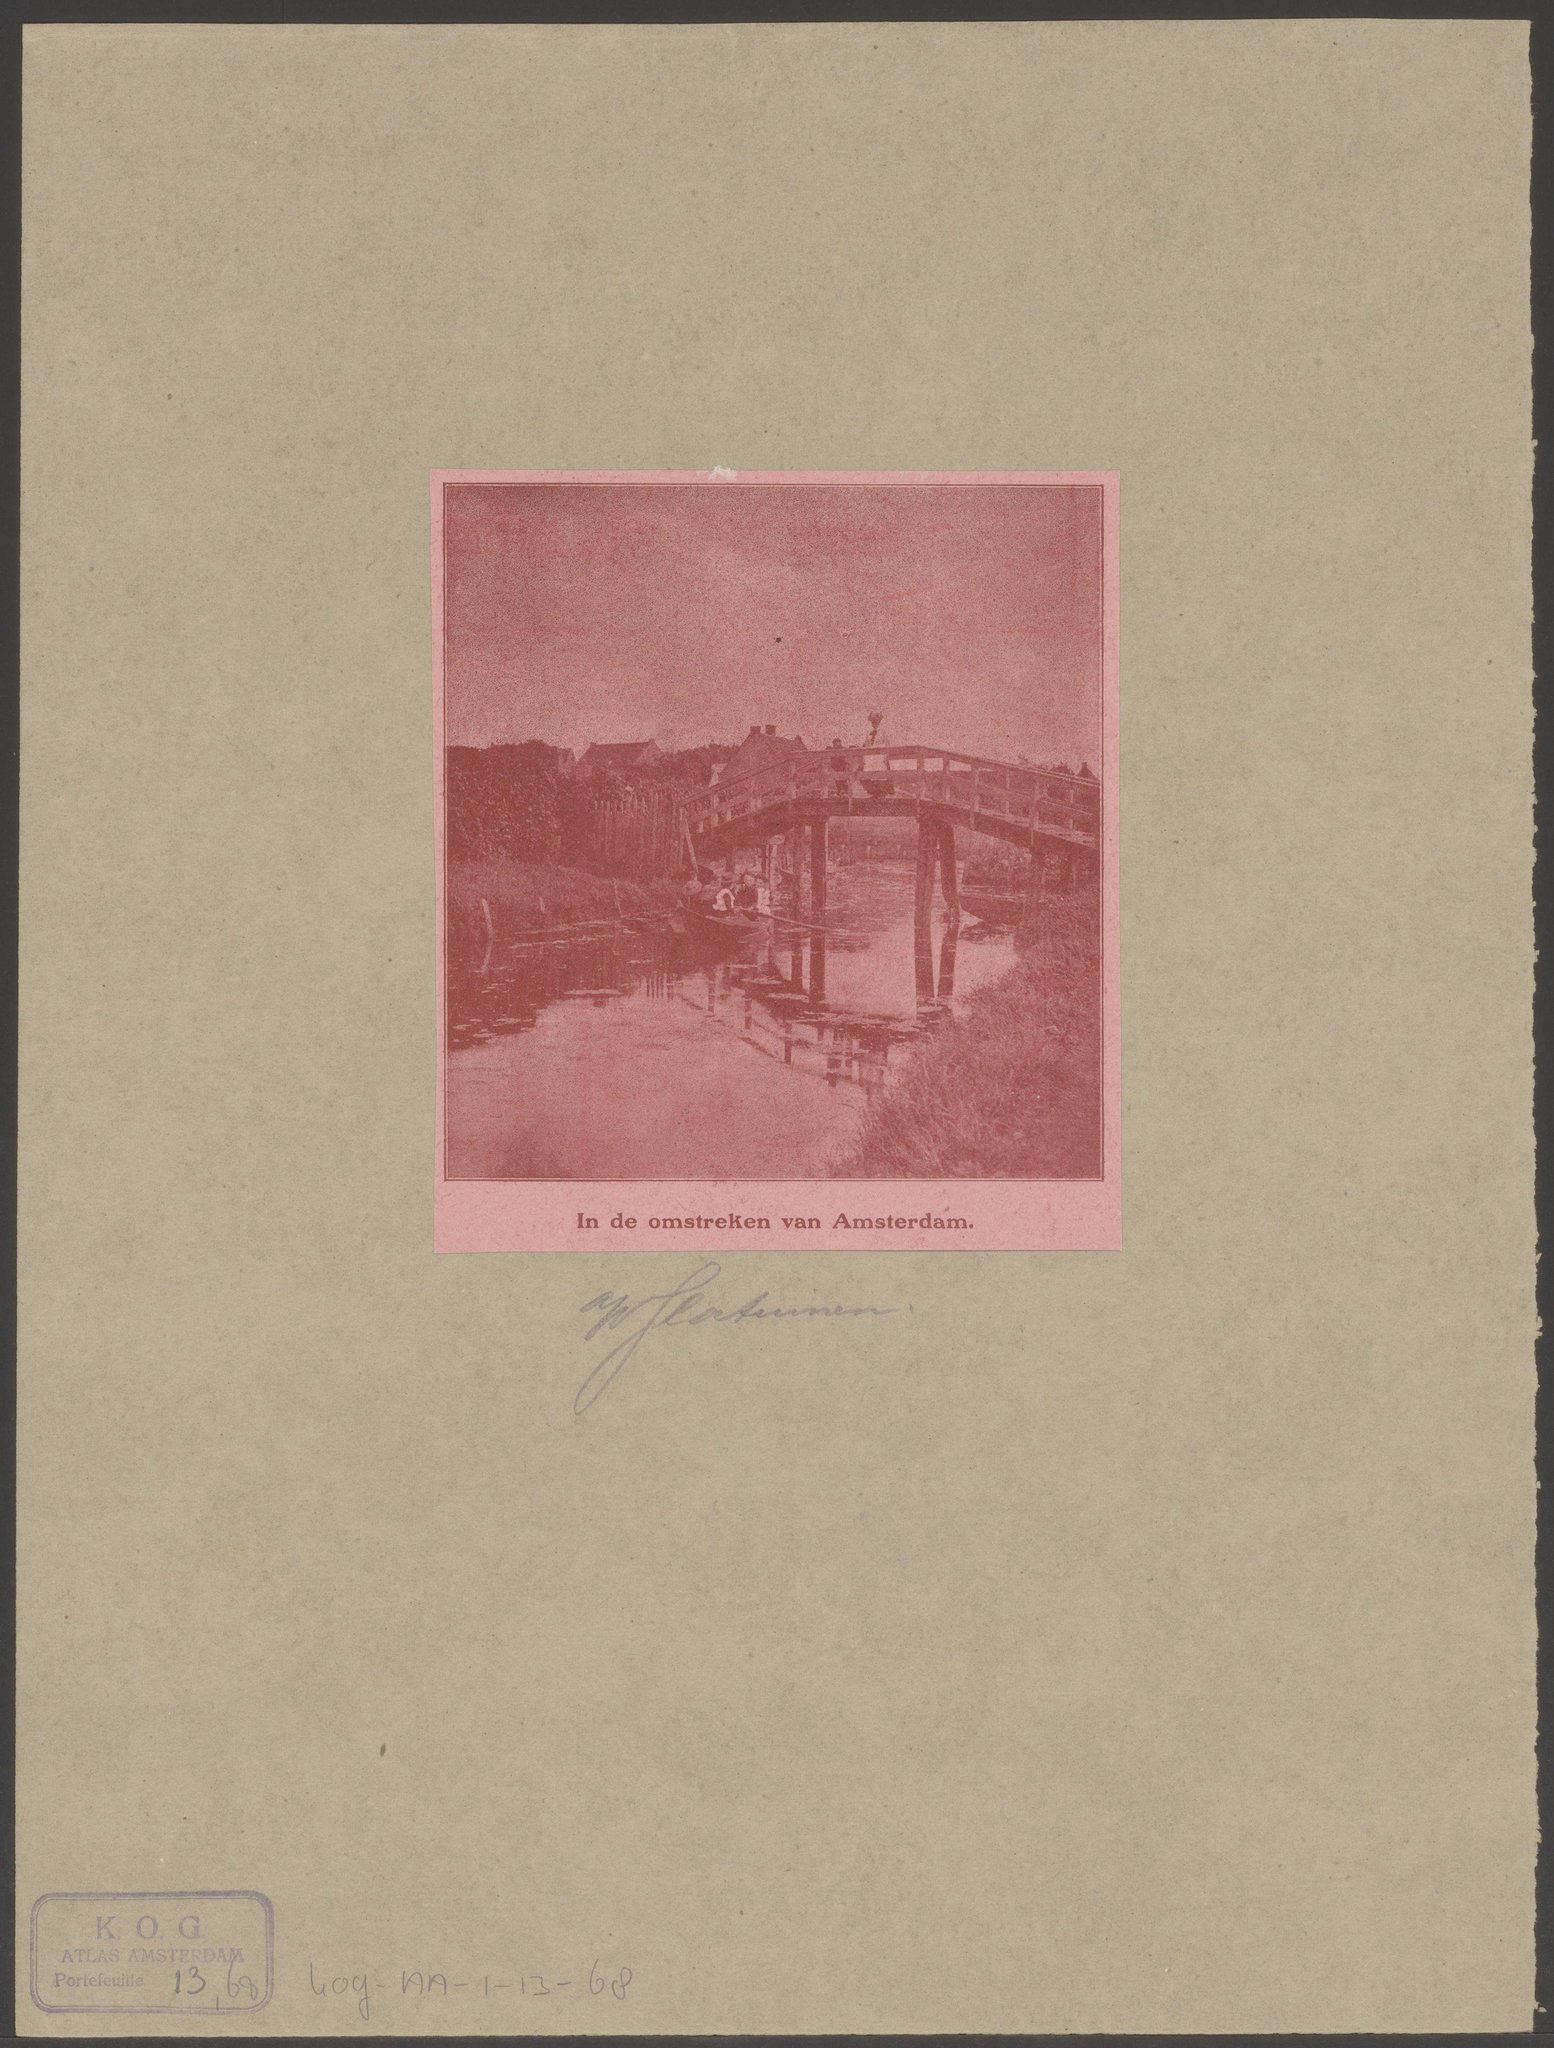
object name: photomechanical print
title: Gezicht bij het Slatuinenpad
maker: Anonymous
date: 1882-1950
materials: paper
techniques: letterpress printing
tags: city-view in general; 'veduta', canal, the usual house or row of houses, bridge in city across river, canal, etc.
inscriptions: inscription: ‘a/d Slatuinen’, collector's mark: ‘13,68’ Lugt 1641b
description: Onderwerpsrubriek binnen de Atlas Amsterdam: Slatuinenpad, Sloterkade, Slootstraat, Slijkstraat, Snoekjesgracht, Sophiapark, Spaarndammerdijk, Spiegelgracht, Spinhuissteeg, Spui, Spuistraat (ook lage Erf), Staalstraat, Stadhouderskade, Steenpad, Stroomarkt.